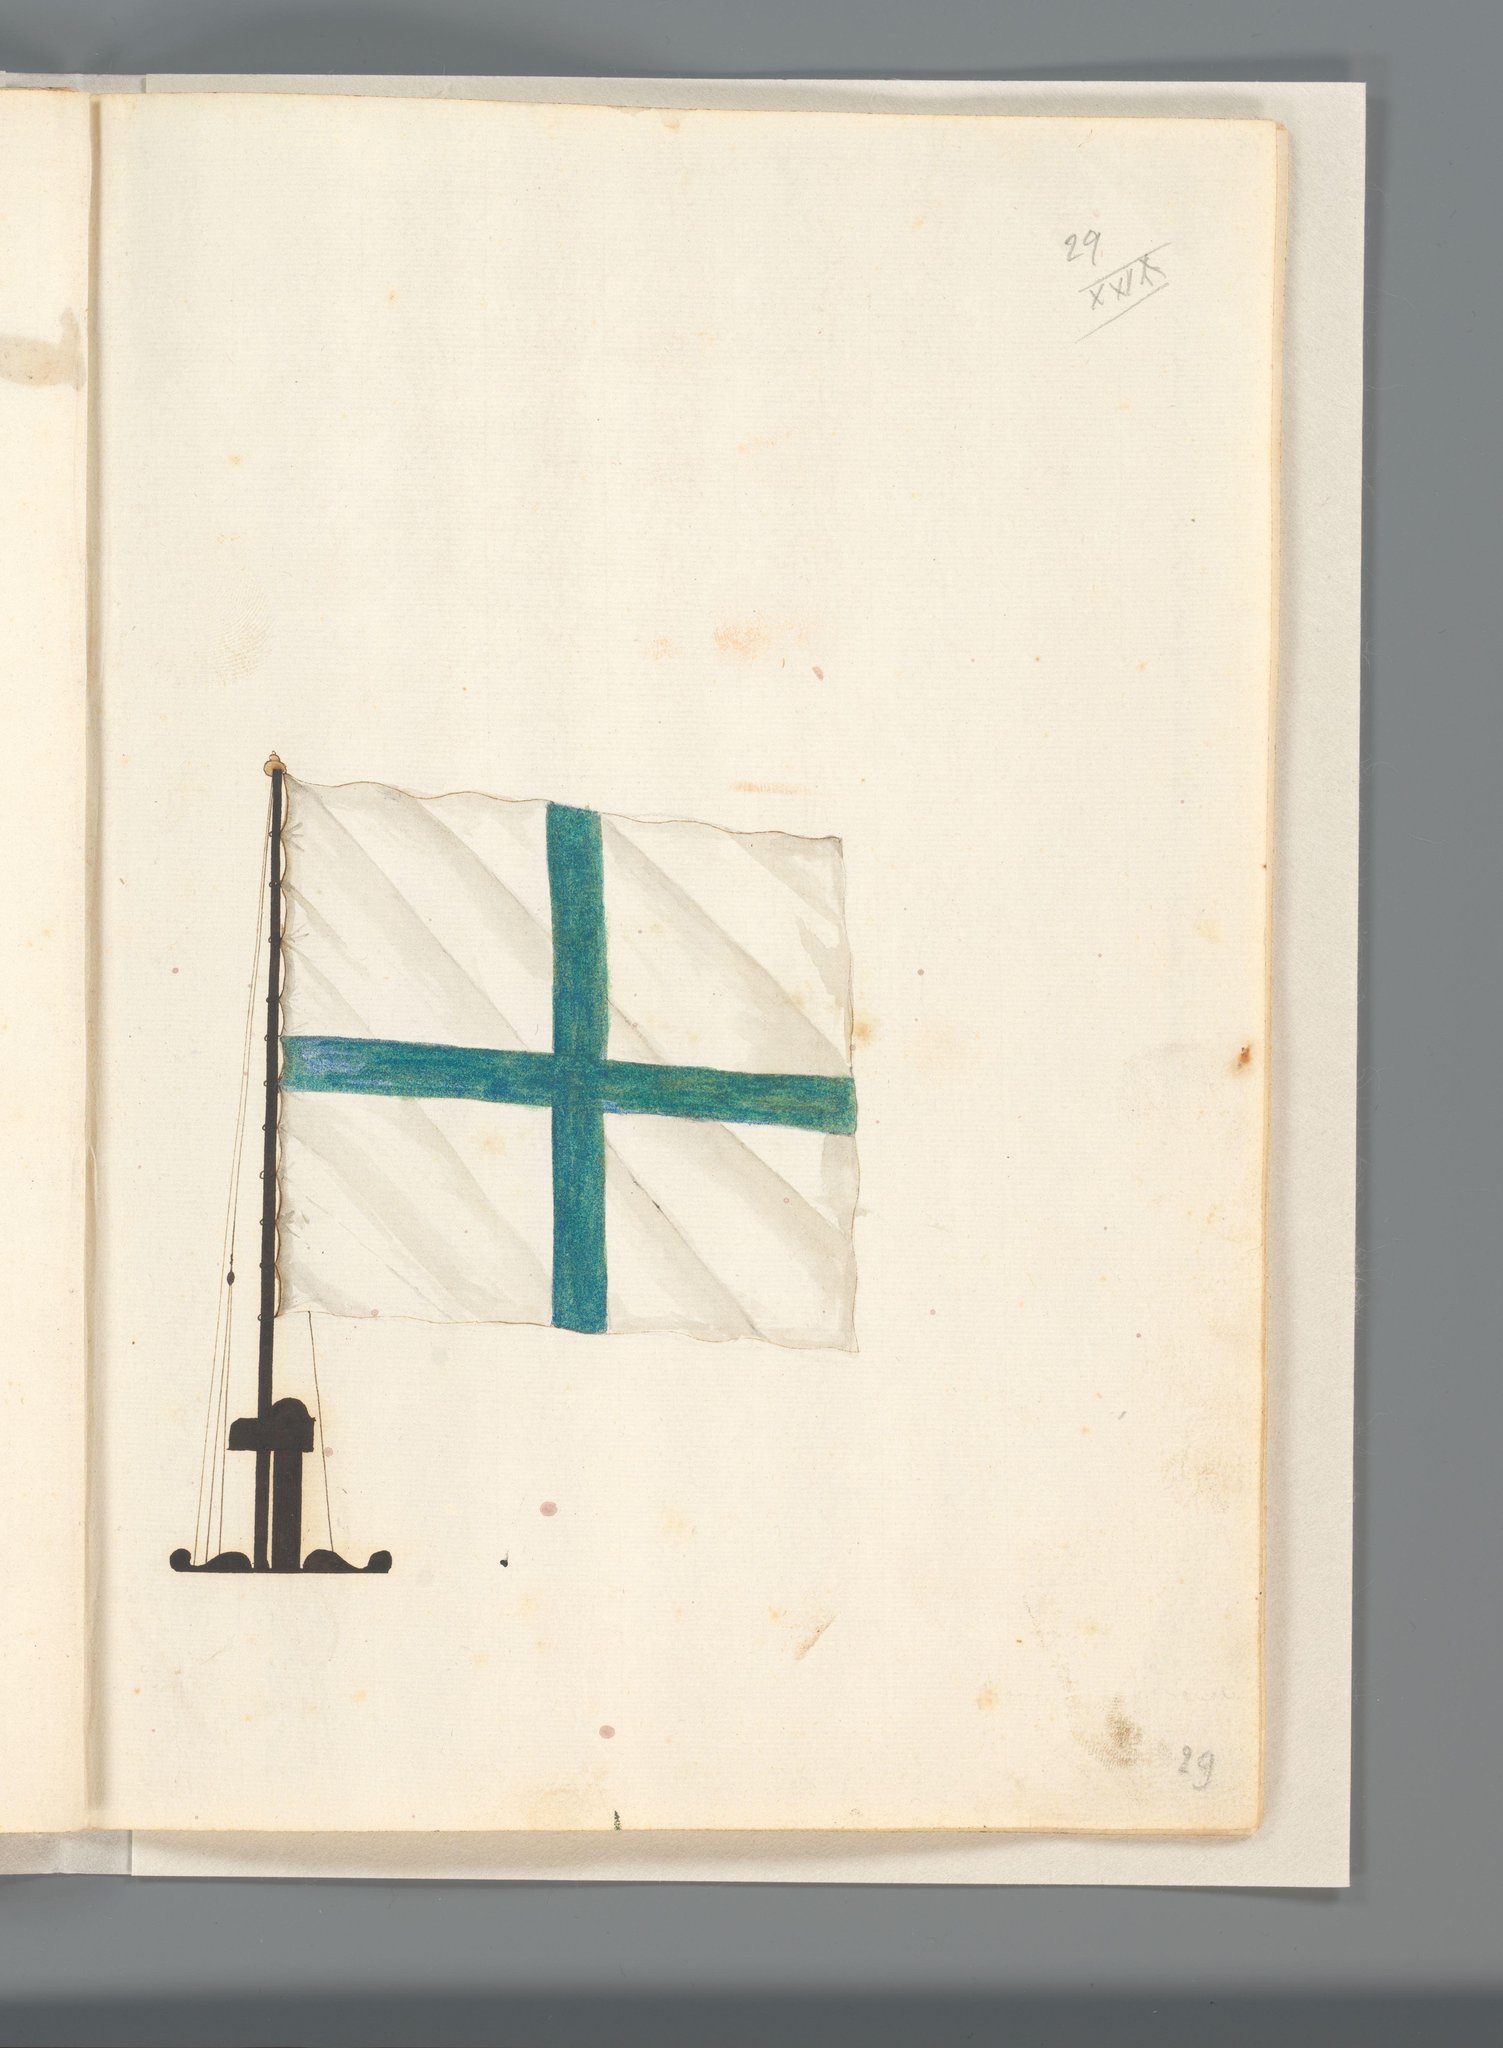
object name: drawing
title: Vlag van Frankrijk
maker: Anonymous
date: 1667-1670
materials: ink, watercolor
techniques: brush, pen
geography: france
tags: flag, colours (as symbol of the state, etc.), france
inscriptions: number: ‘29 / XXIX / 29’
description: Vlag van Frankrijk. Witte vlag met blauw staand kruis, geïdentificeerd als een Franse handelsvlag. Vlag op vlaggensteng en mastvoet. Afgebeeld op folio 15r. Onderdeel van een vlaggenboek met vlaggen uit Europa, Noord-Afrika, Nabije en Verre Oosten.